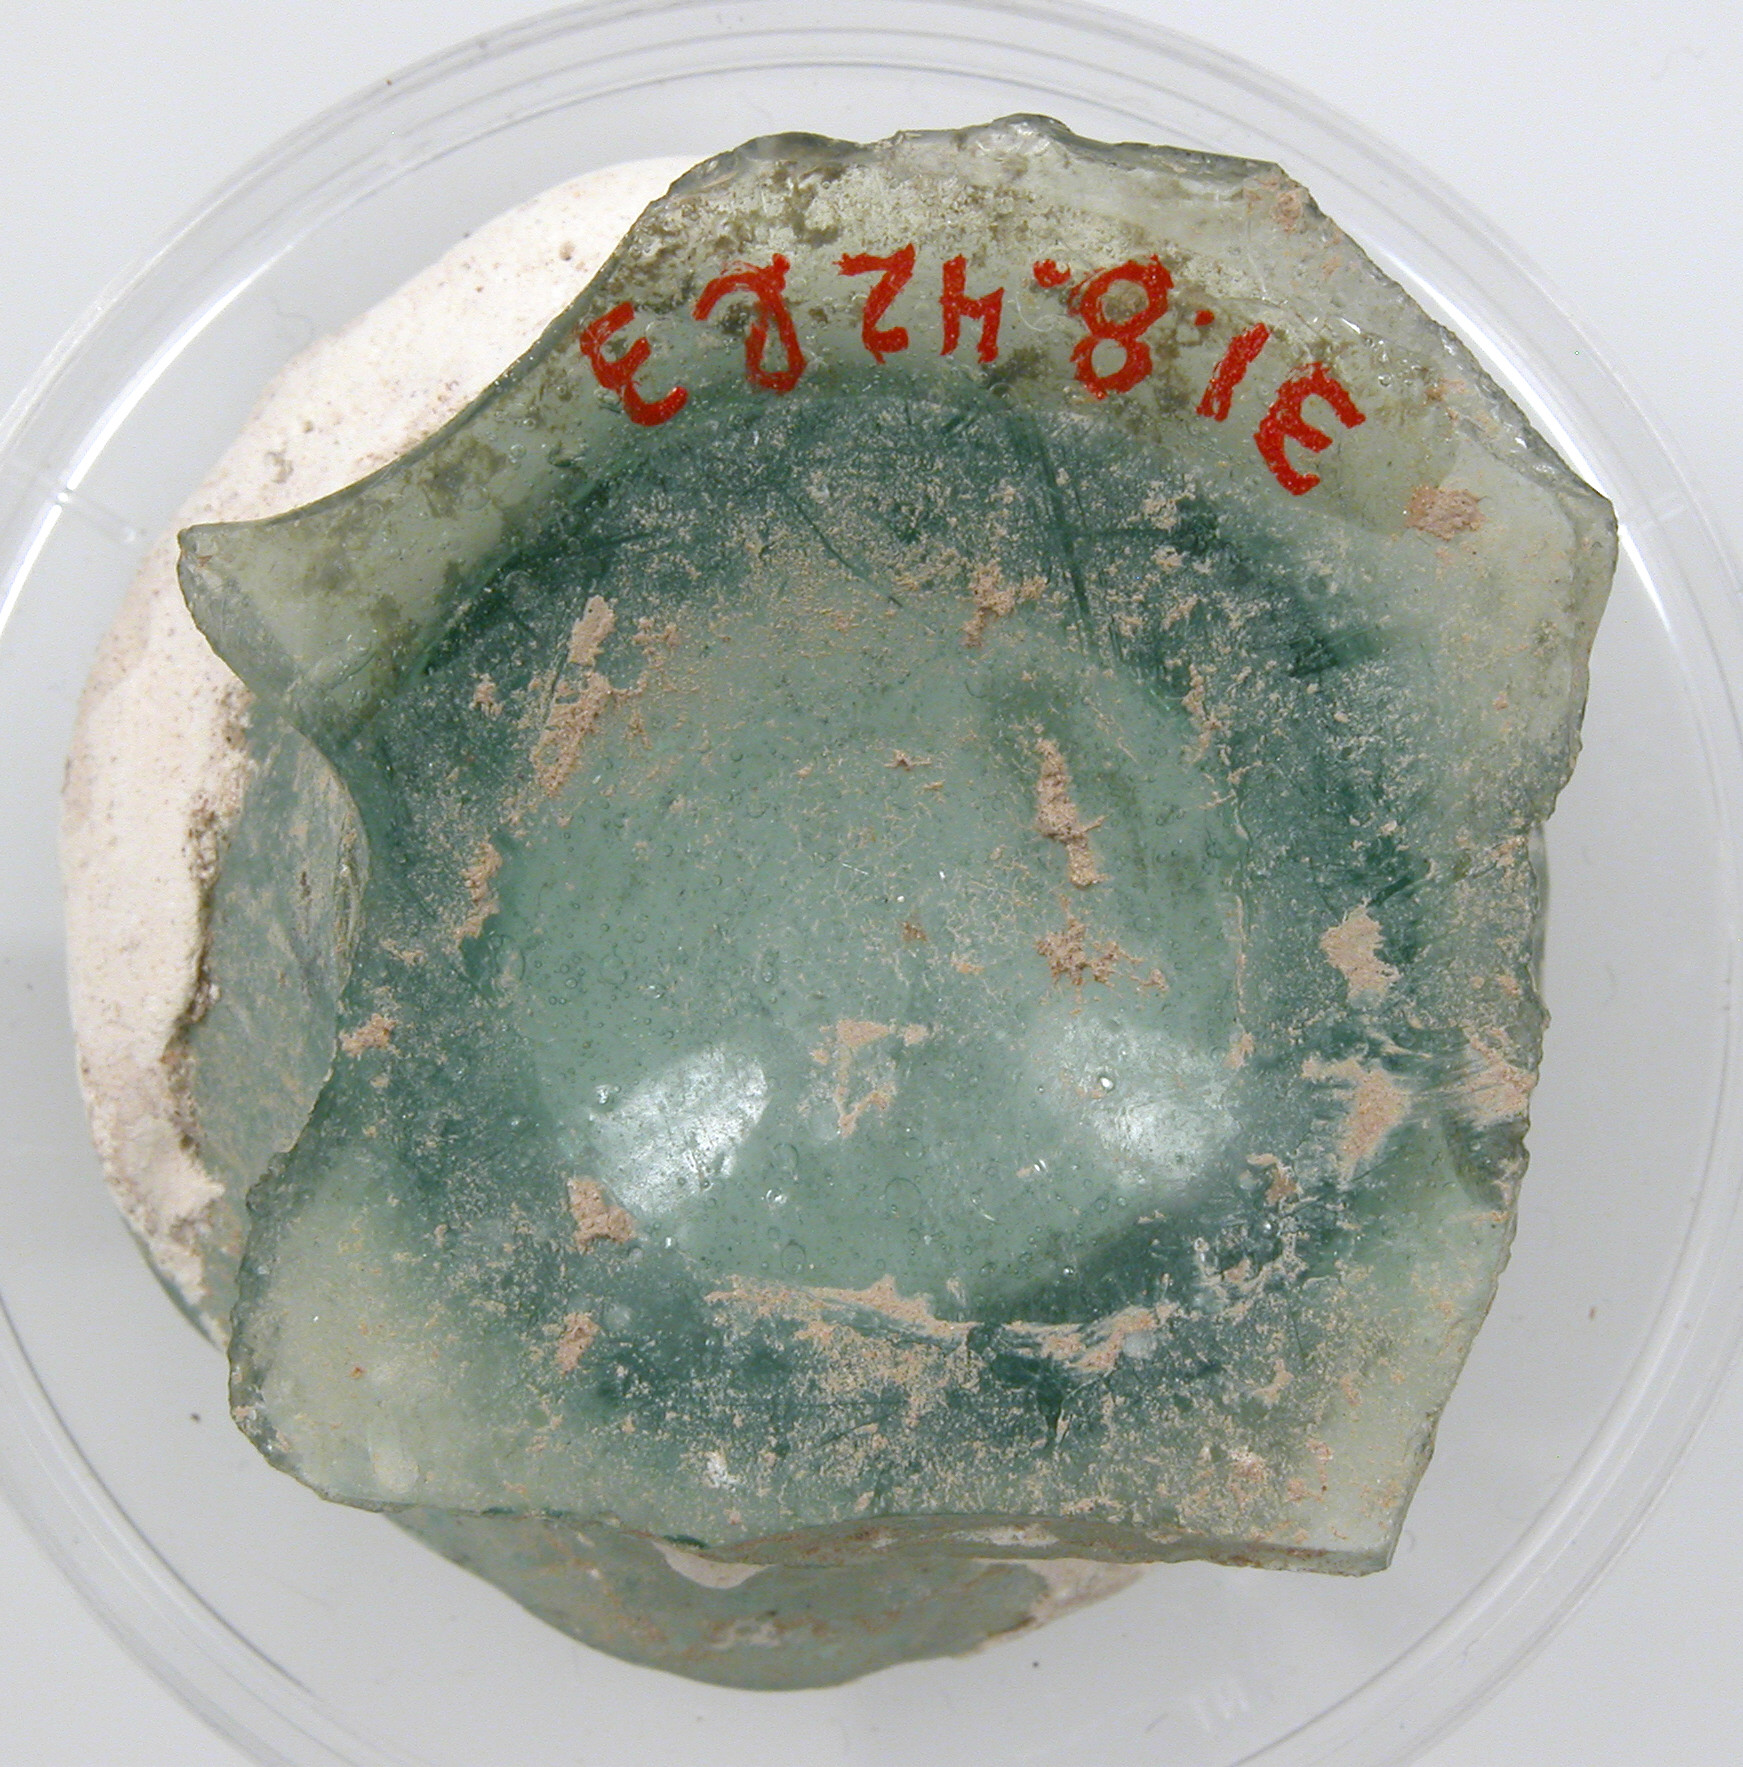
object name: fragment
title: Foot of a Vessel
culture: coptic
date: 301-400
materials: glass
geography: egypt